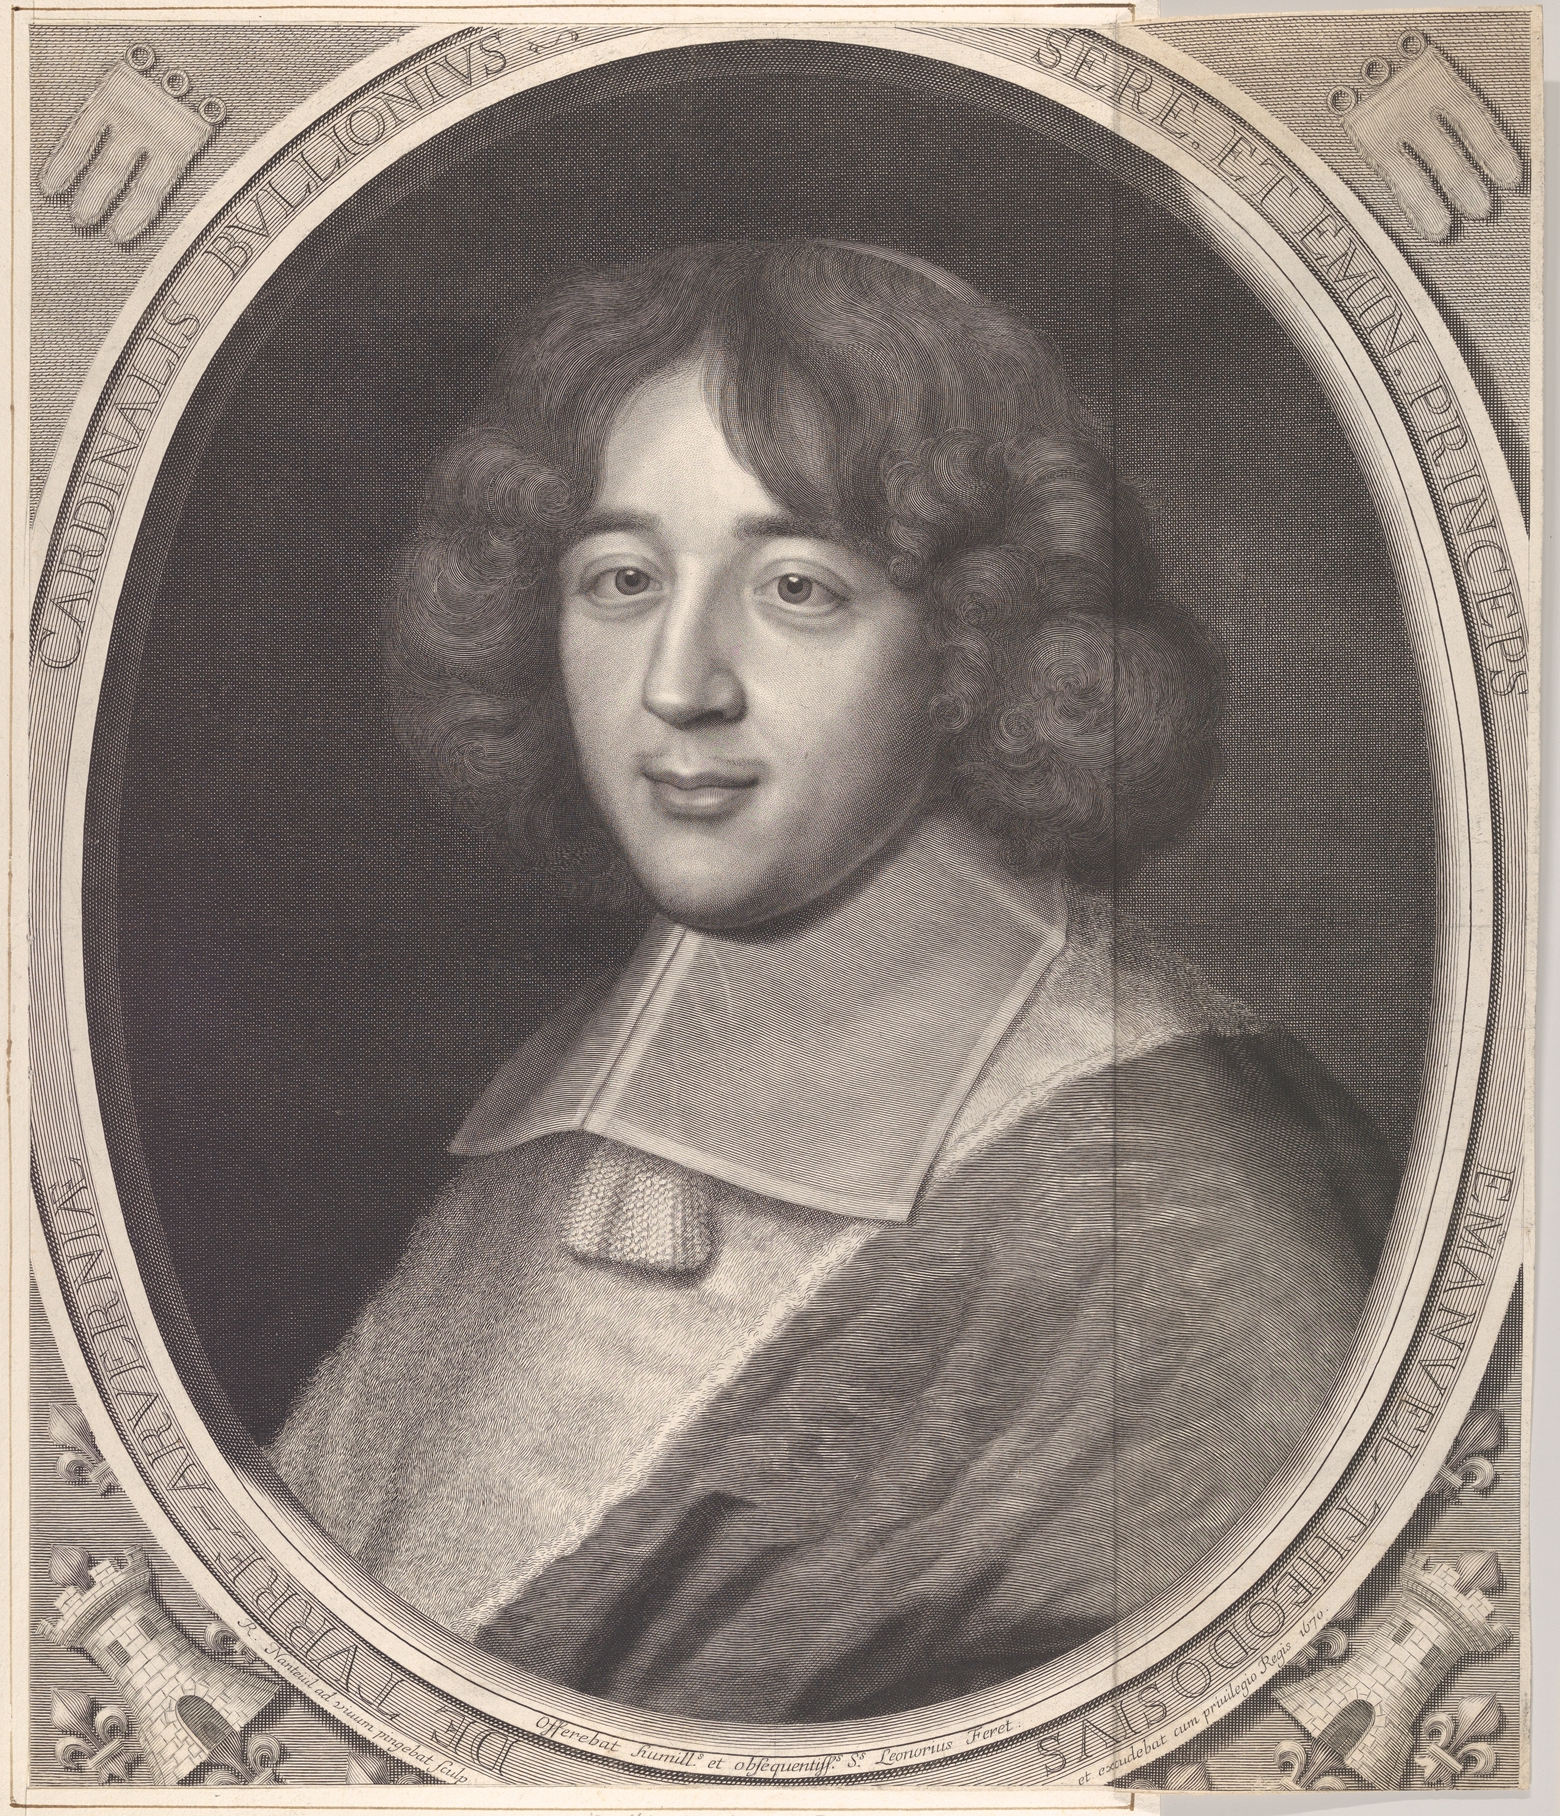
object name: print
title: Emmanuel-Théodose de La Tour d'Auverge, cardinal de Bouillon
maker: robert nanteuil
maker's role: artist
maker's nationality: french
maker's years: 1623-1678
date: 1670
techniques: engraving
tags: men,portraits